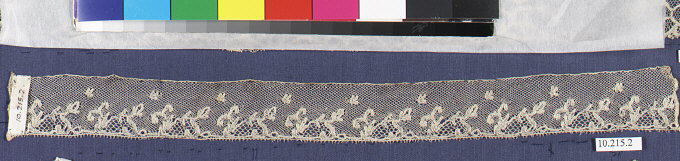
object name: piece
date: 1801-1900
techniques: lace